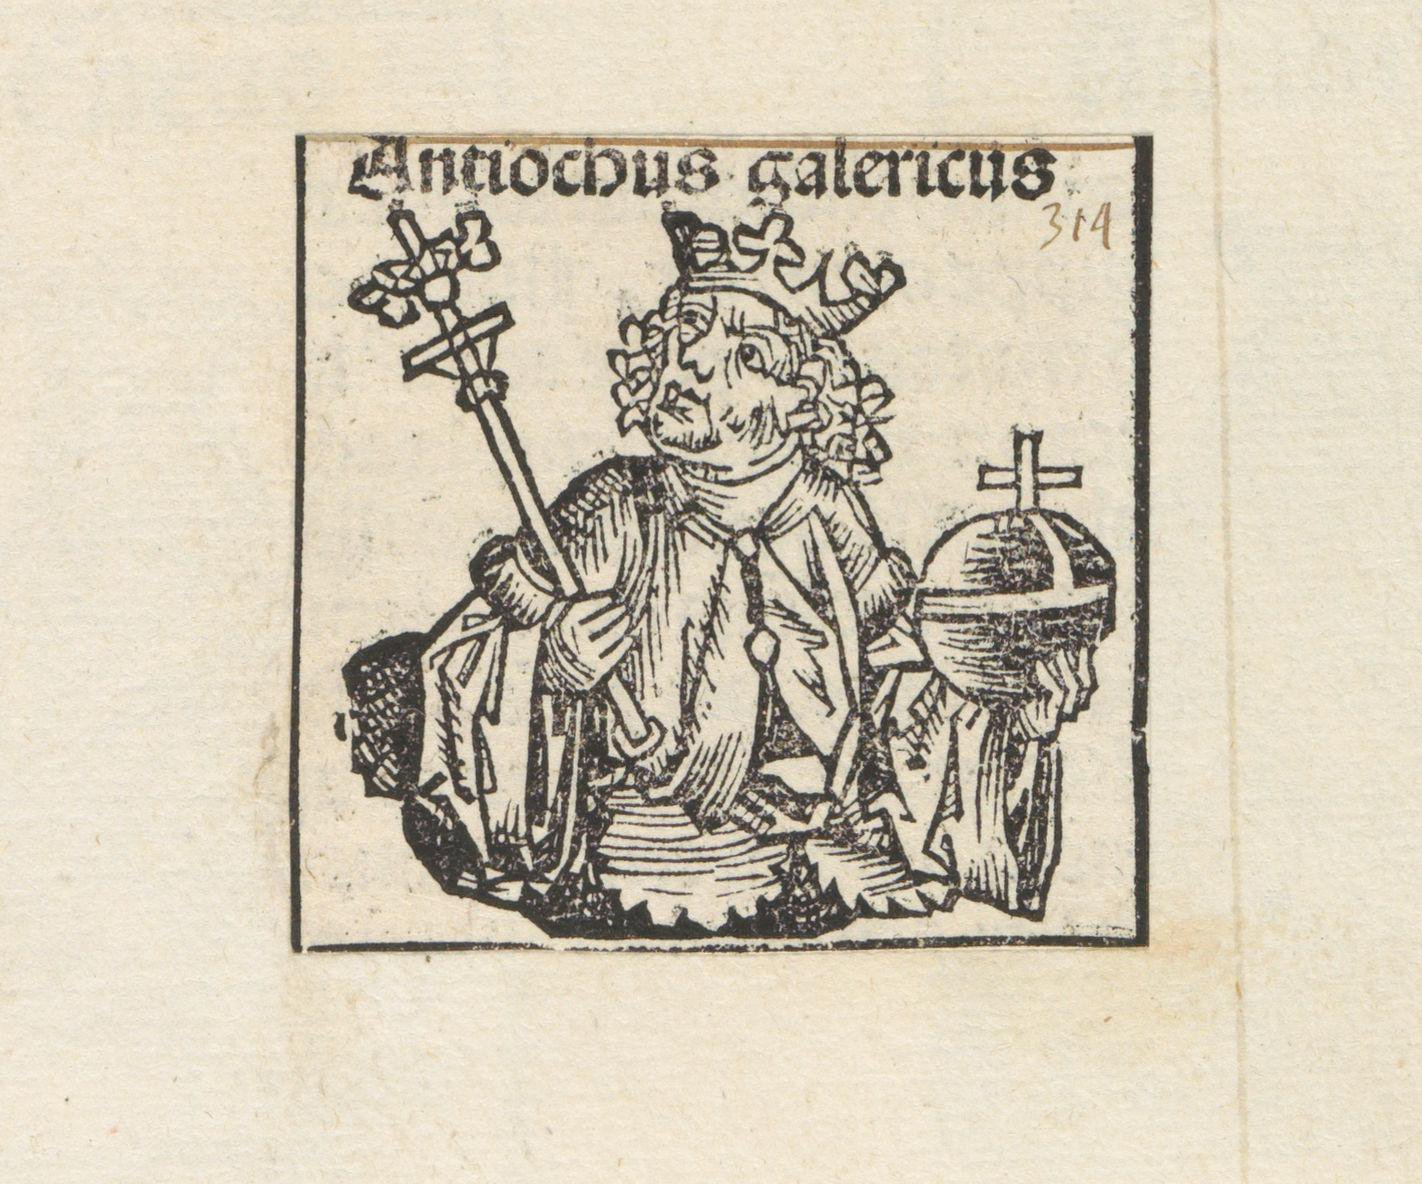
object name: book illustration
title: Antiochus galericus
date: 1493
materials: paper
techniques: letterpress printing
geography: nuremberg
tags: king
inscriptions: inscription: ‘314’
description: Een bloemkelk met een koning, zijn hoofd naar links gekeerd. De man heeft een rijksappel en een scepter in zijn handen. De voorstelling is onderdeel van de opeenvolging Syrische koningen in de Liber Chronicarum. De tekst identificeert hem als Seleucus II Callinicus. De prent maakt deel uit van een album.